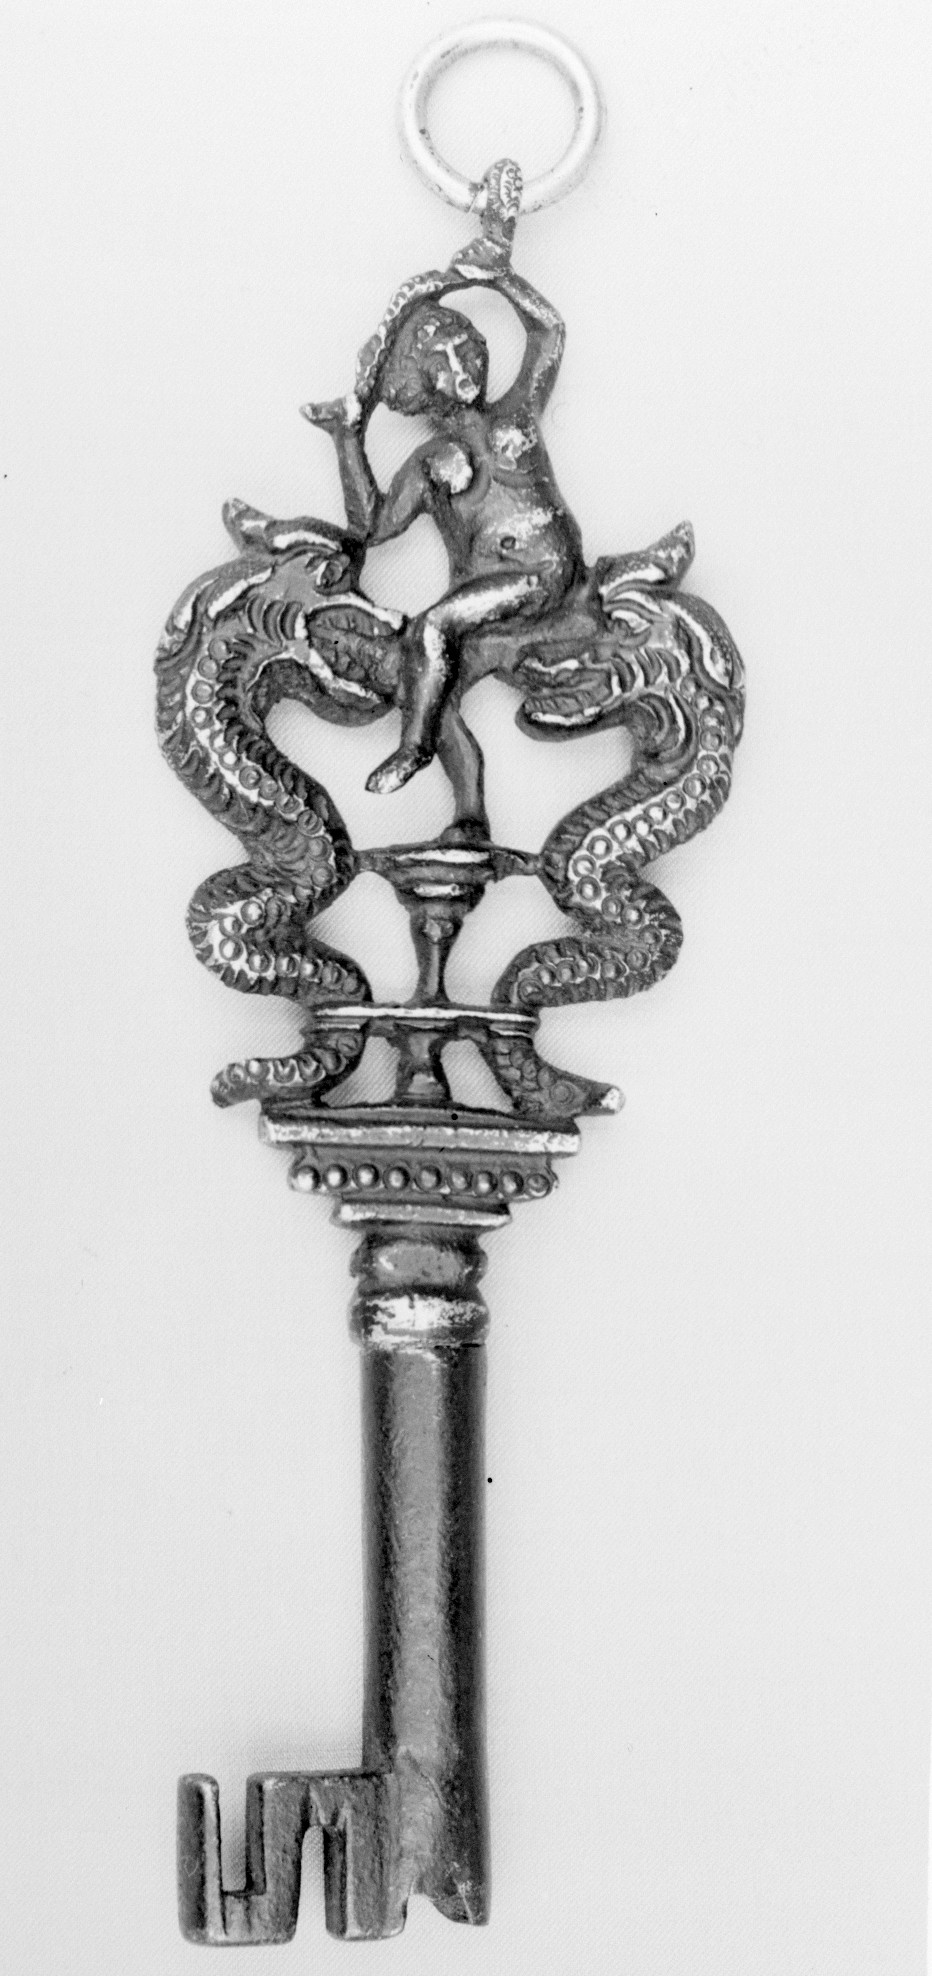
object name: key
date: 1601-1633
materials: iron